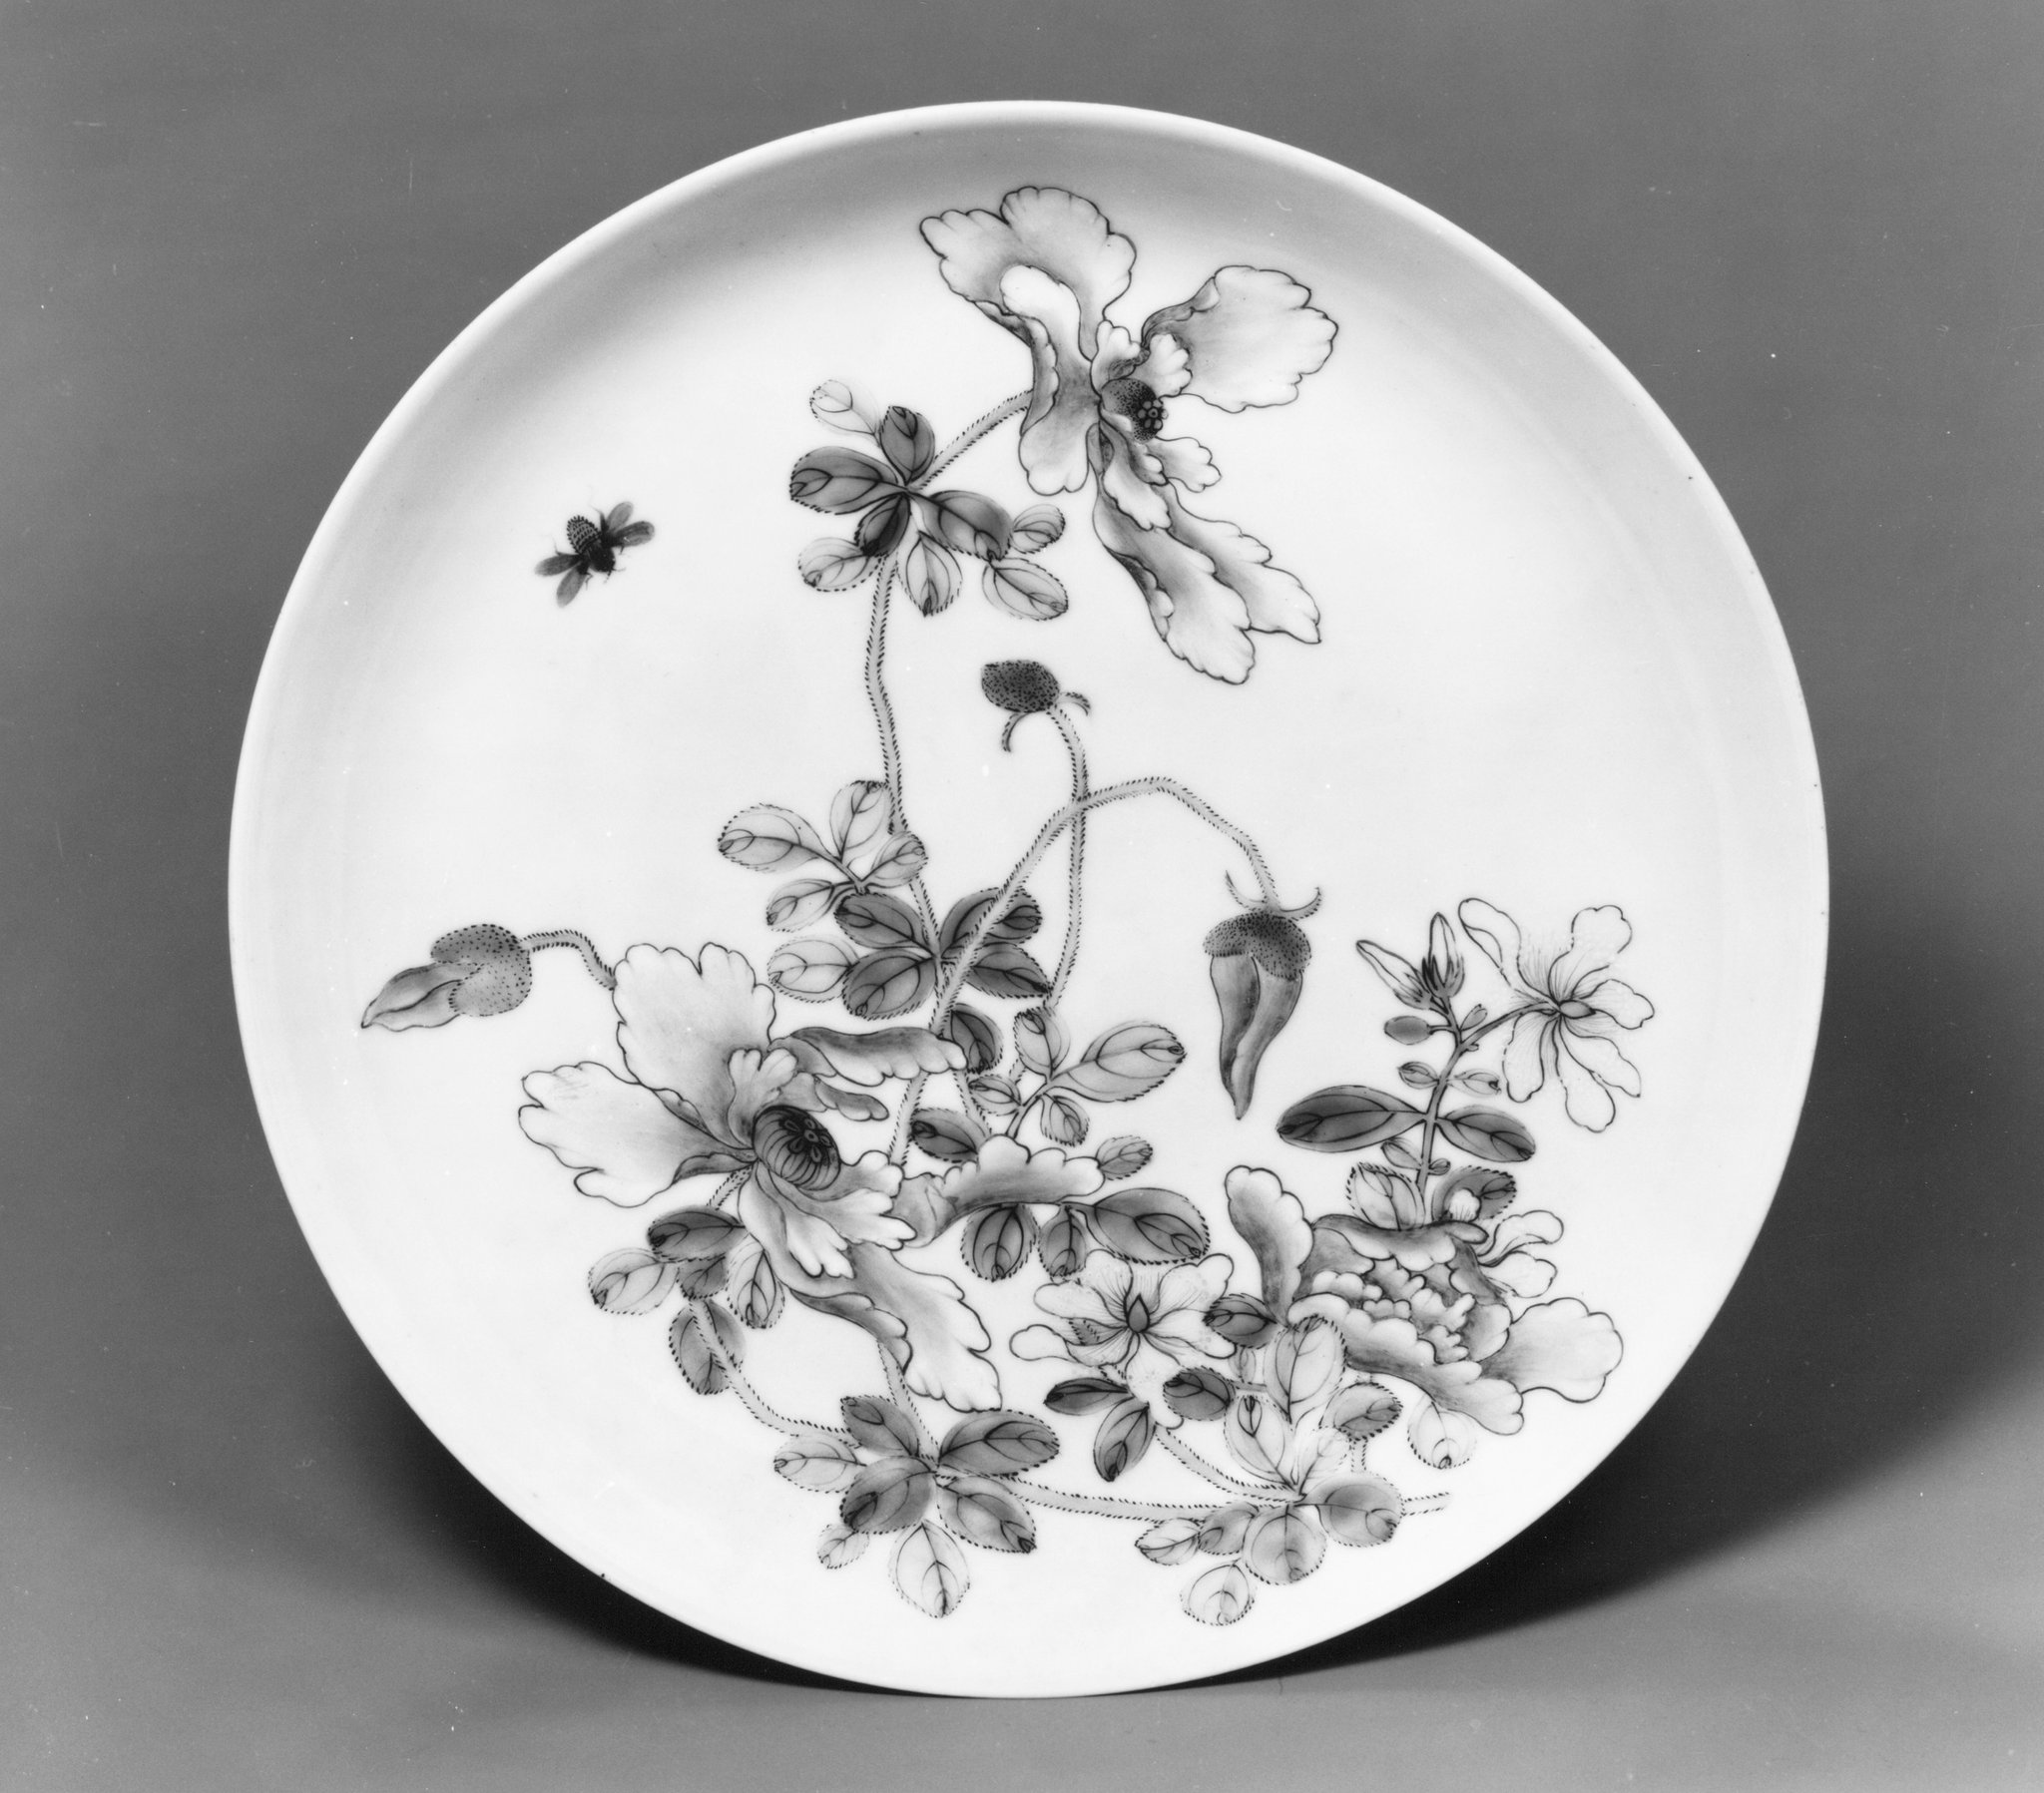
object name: dish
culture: chinese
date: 1730-1750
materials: enamel, glaze, porcelain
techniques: overglaze, painting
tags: insects,flowers